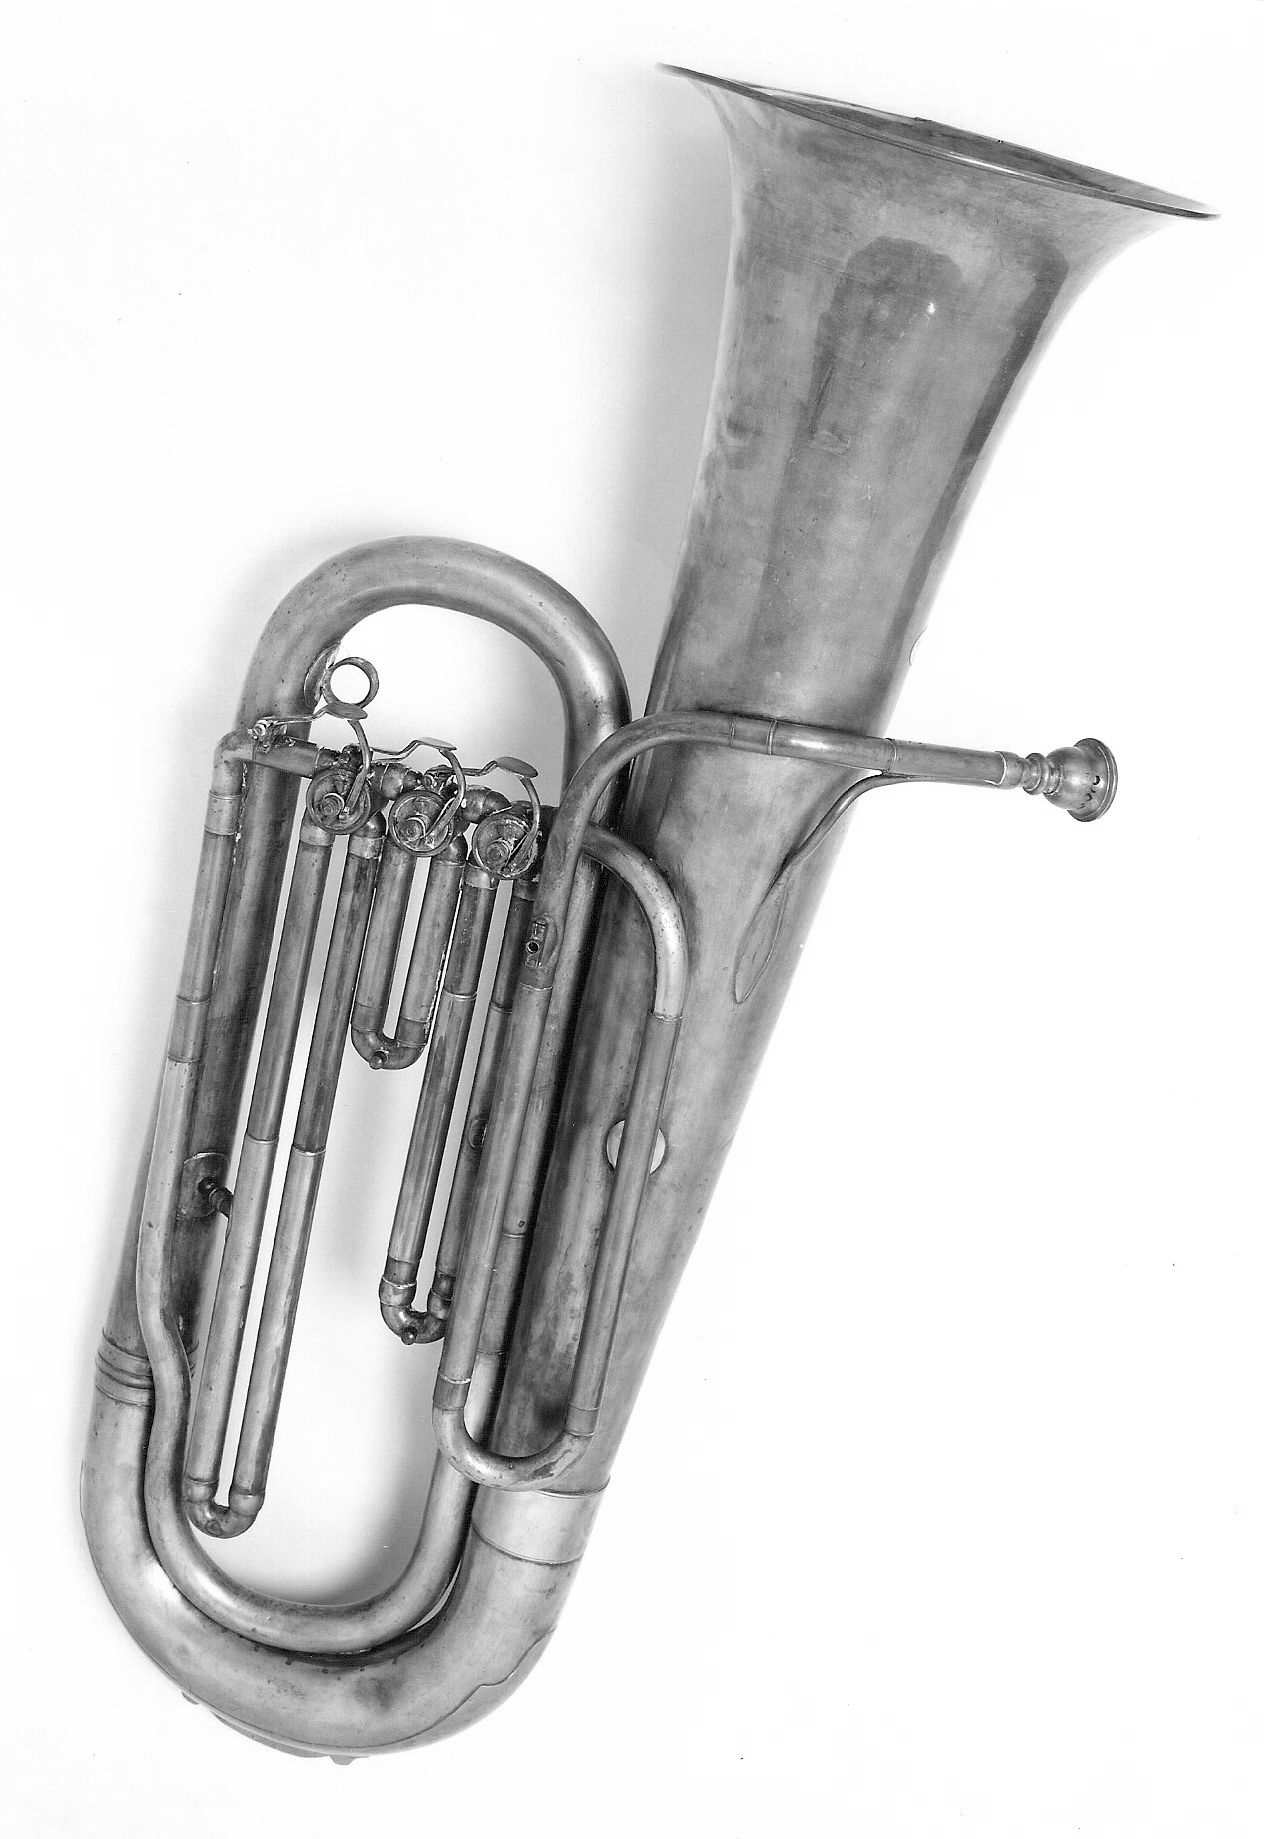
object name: contrabass saxhorn in e flat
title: Contrabass Saxhorn in E-flat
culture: american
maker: c. a. zoebisch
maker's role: maker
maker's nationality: american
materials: brass, nickel, silver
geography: united states